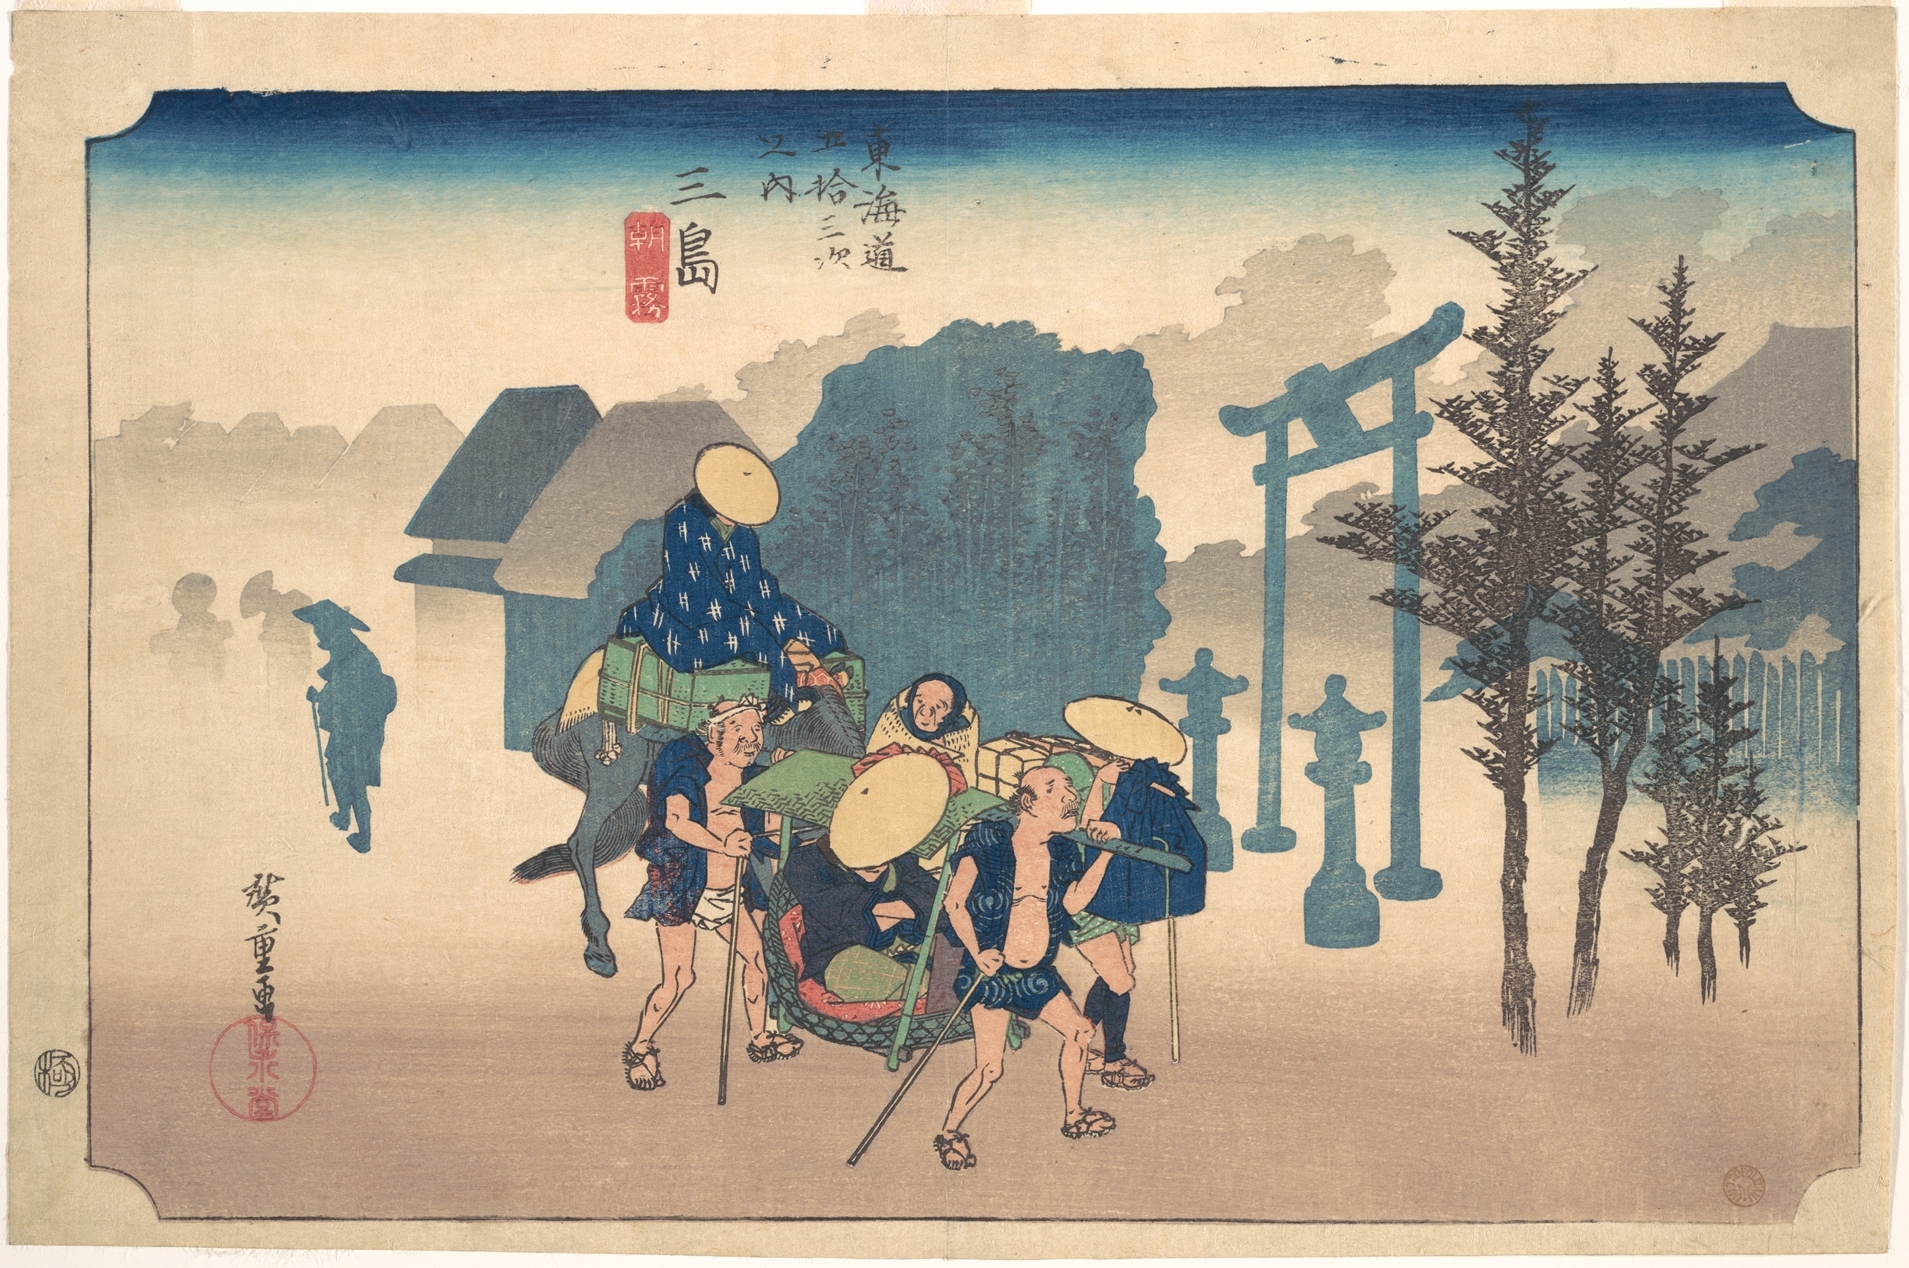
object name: print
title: Morning Mist at Mishima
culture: japanese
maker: utagawa hiroshige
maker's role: artist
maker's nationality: japanese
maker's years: 1797-1858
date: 1833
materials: ink, paper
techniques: woodblock print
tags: animals,gates,men